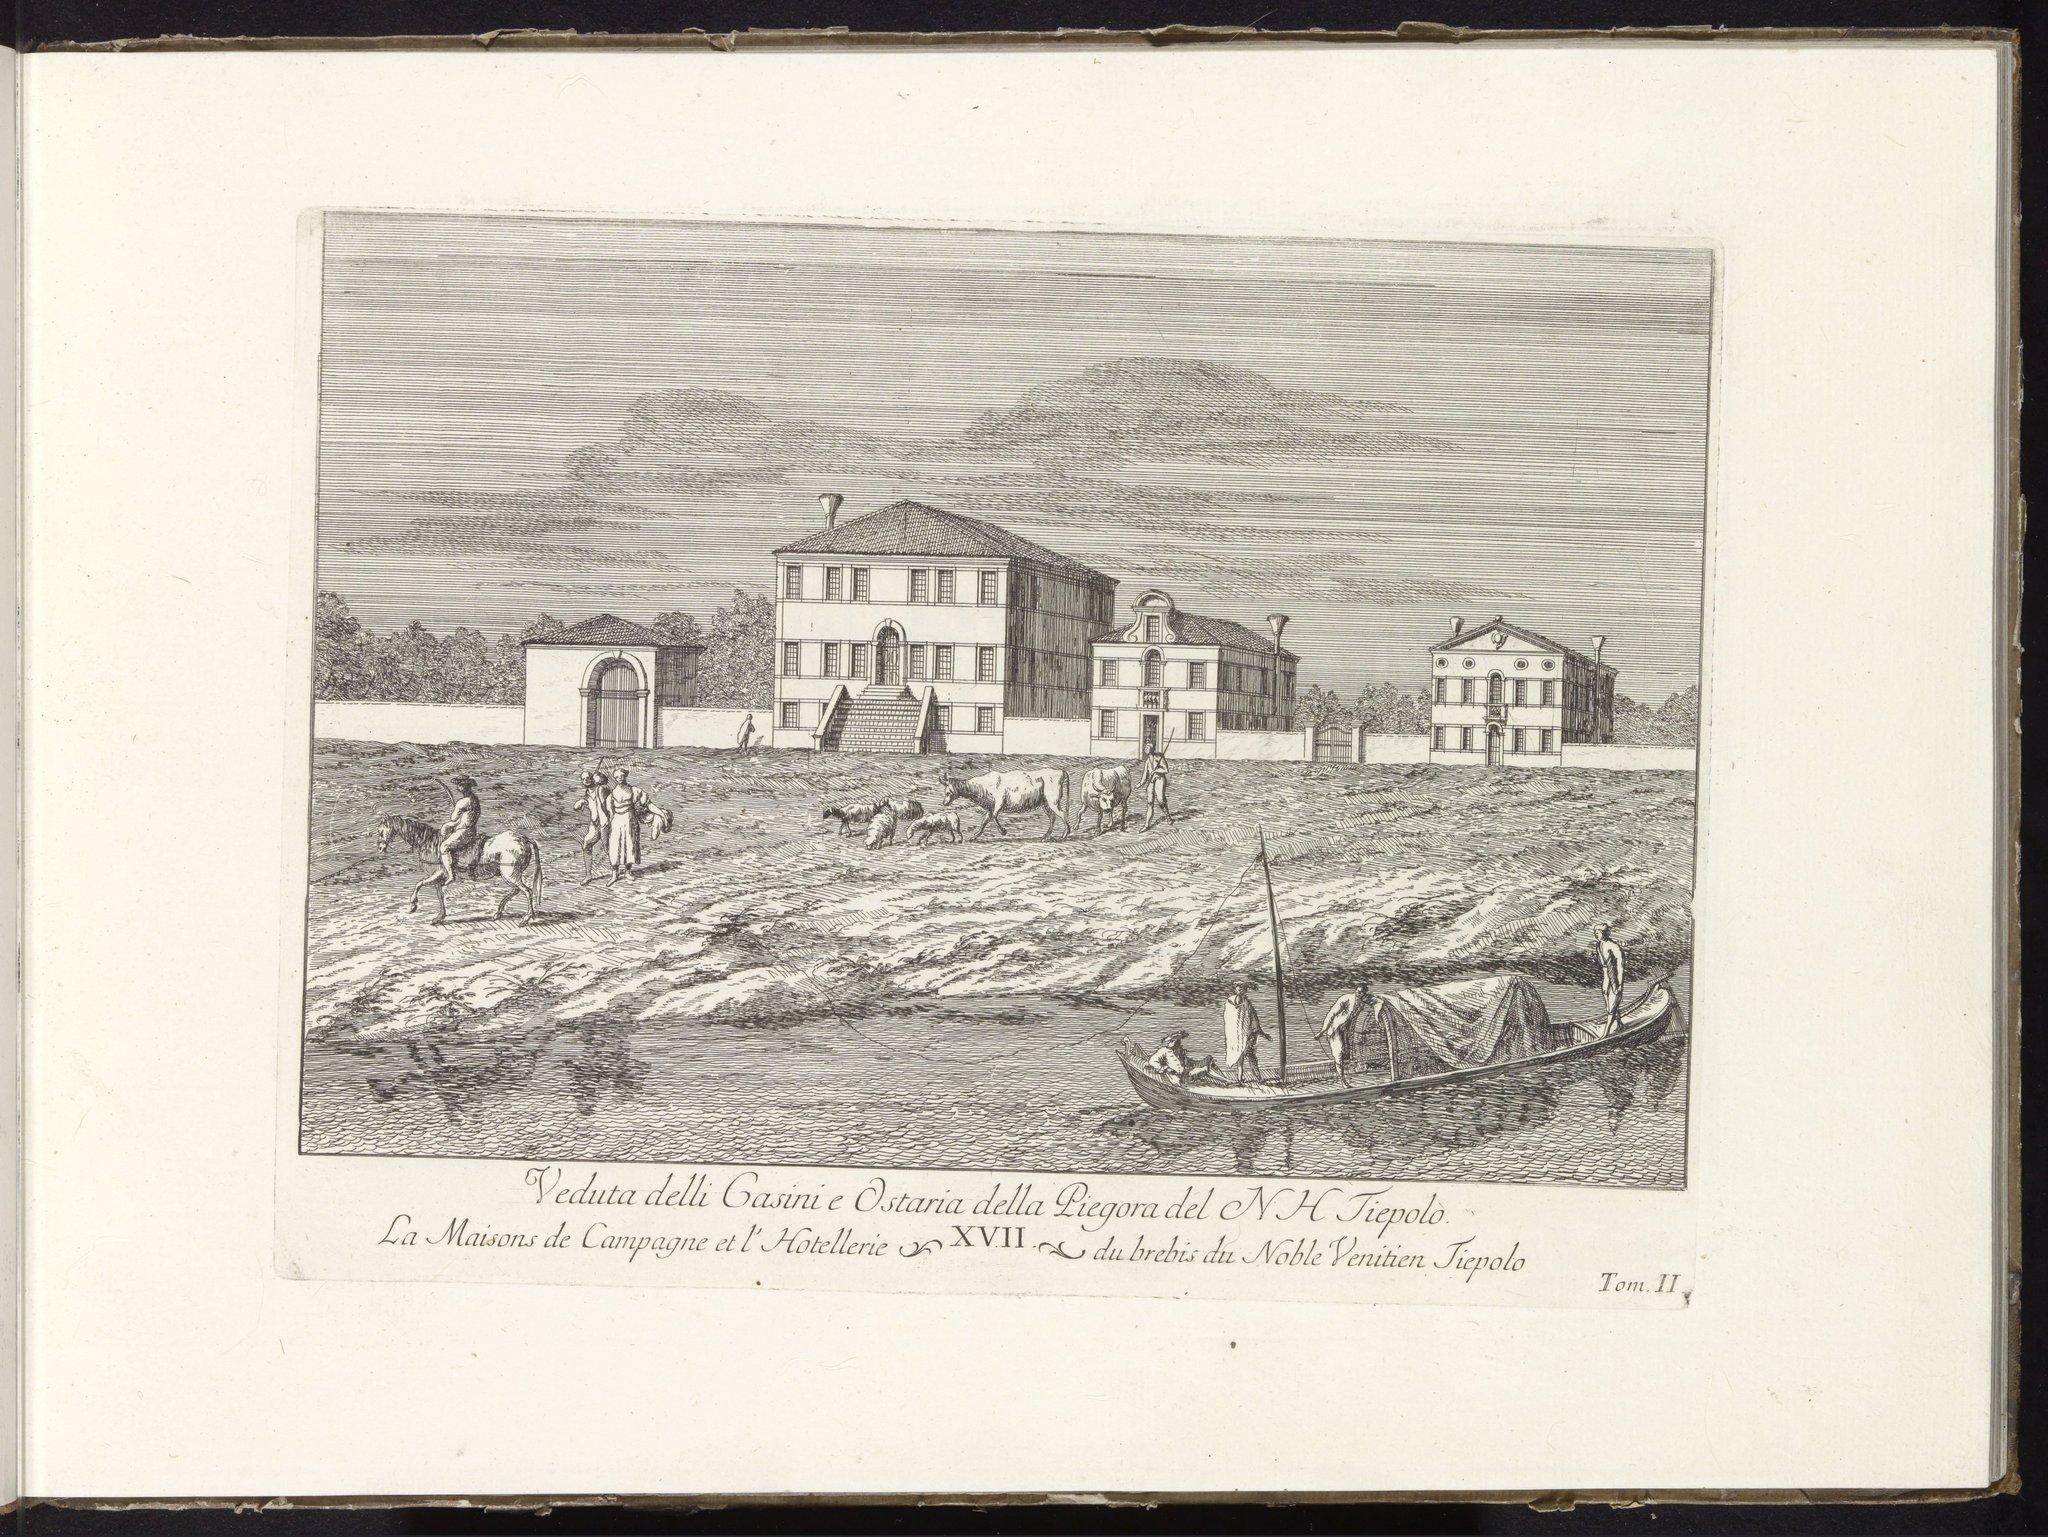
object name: print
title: Huizen en osteria aan de Brenta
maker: giovanni francesco costa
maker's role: draughtsman, painter, print maker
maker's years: -1773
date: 1750-1760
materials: paper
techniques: etching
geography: venice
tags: river, herding, herdsman, herdswoman, shepherd, shepherdess, cowherd, etc., inn, coffee-house, public house, etc., tow-boat, towing-barge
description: Huizen en een osteria aan de rivier de Brenta. Voor de gebouwen lopen herders met vee. Op het water vaart een trekschuit. Genummerd midden onder: XVII en rechtsonder: Tom: II. Deze prent maakt deel uit van een album.